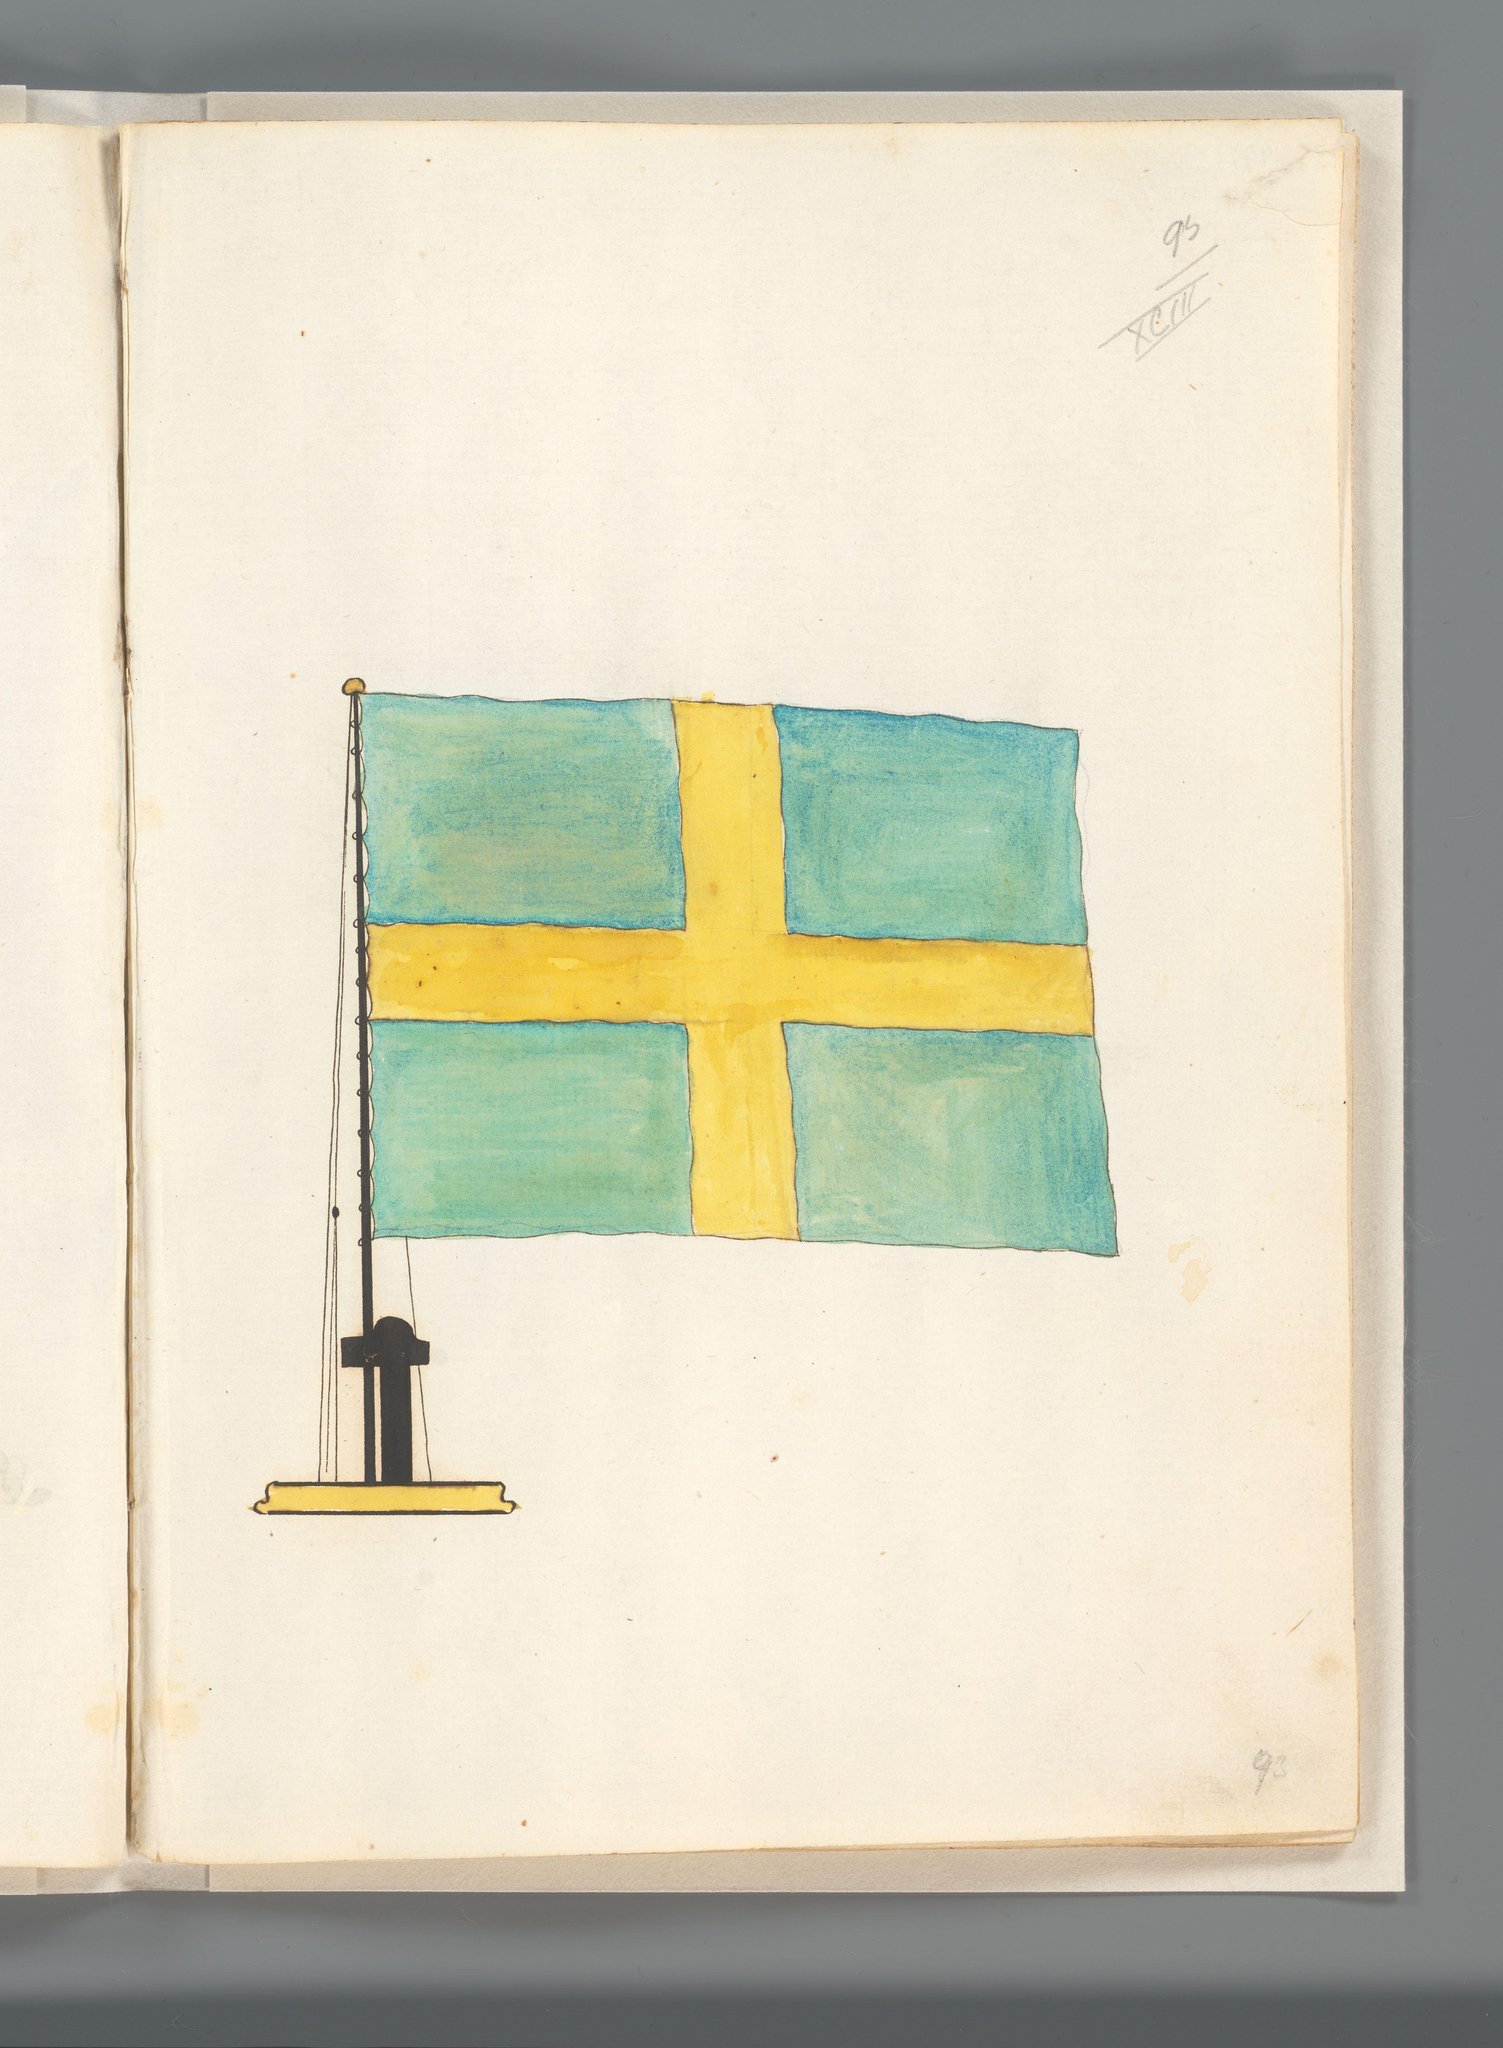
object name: drawing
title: Vlag van Zweden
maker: Anonymous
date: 1667-1670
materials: ink, paper, watercolor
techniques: brush, pen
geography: france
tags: flag, colours (as symbol of the state, etc.)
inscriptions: number: ‘93 / XCIII / 93’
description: Vlag van Zweden. Geel kruis op een blauw veld. Vlag op vlaggensteng en mastvoet. Afgebeeld op folio 47r. Onderdeel van een vlaggenboek met vlaggen uit Europa, Noord-Afrika, Nabije en Verre Oosten.